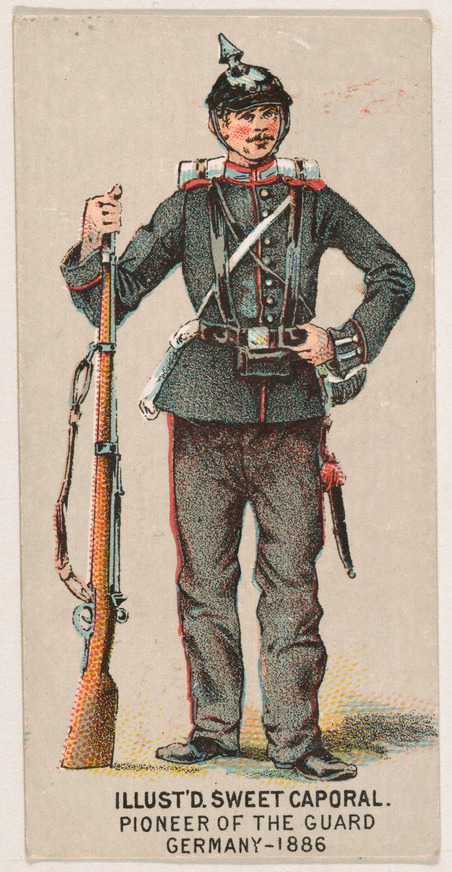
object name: print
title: Pioneer of the Guard, Germany, 1886, from the Military Series (N224) issued by Kinney Tobacco Company to promote Sweet Caporal Cigarettes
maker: kinney brothers tobacco company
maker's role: publisher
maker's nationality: american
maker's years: 1869-2011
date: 1888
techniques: color lithograph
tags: military,firearms,men